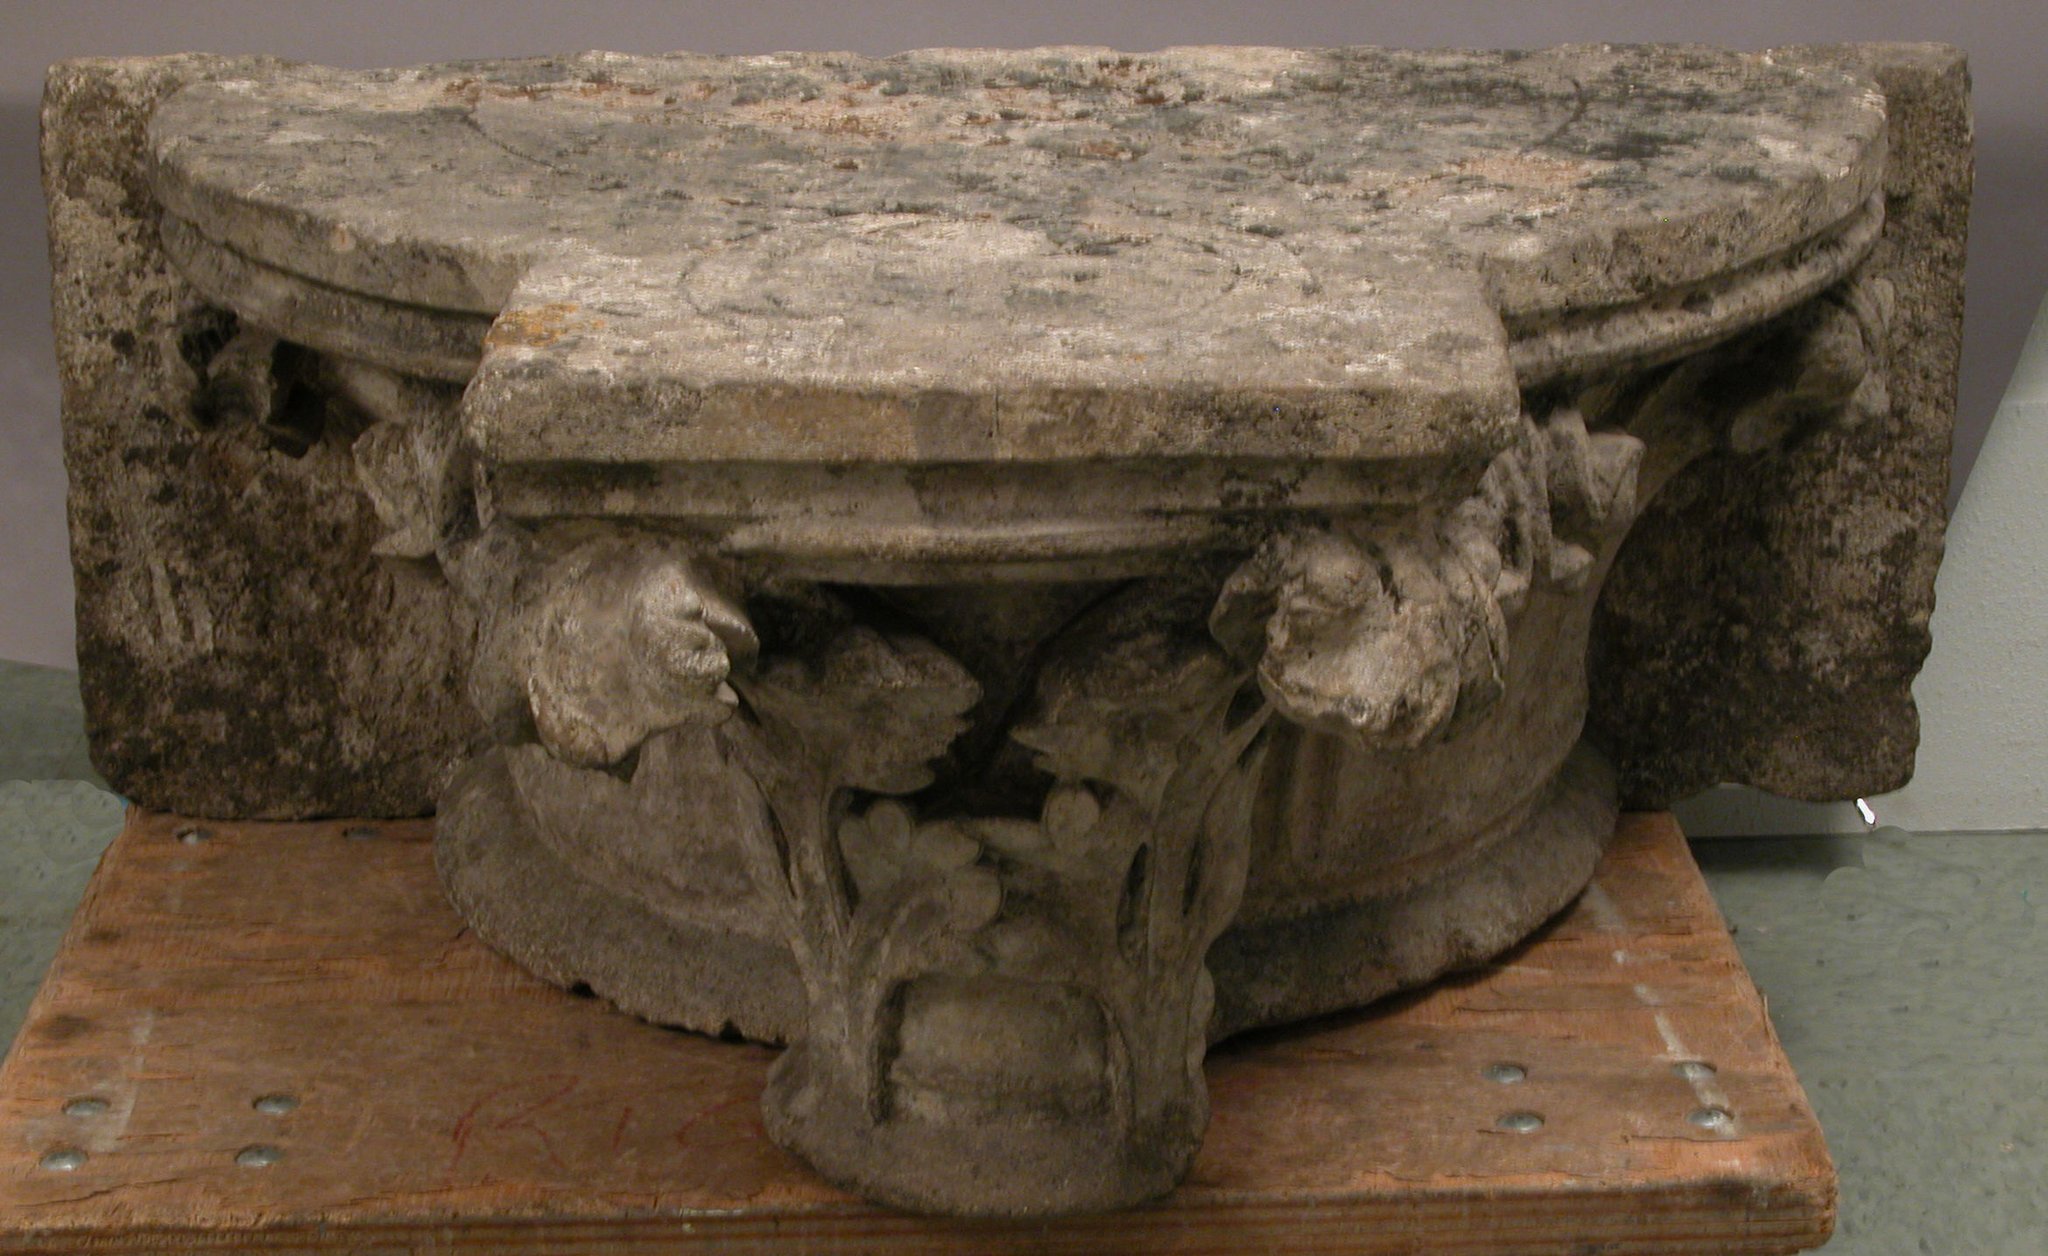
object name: capital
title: Engaged Clustered Captial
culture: french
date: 1201-1300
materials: limestone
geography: france